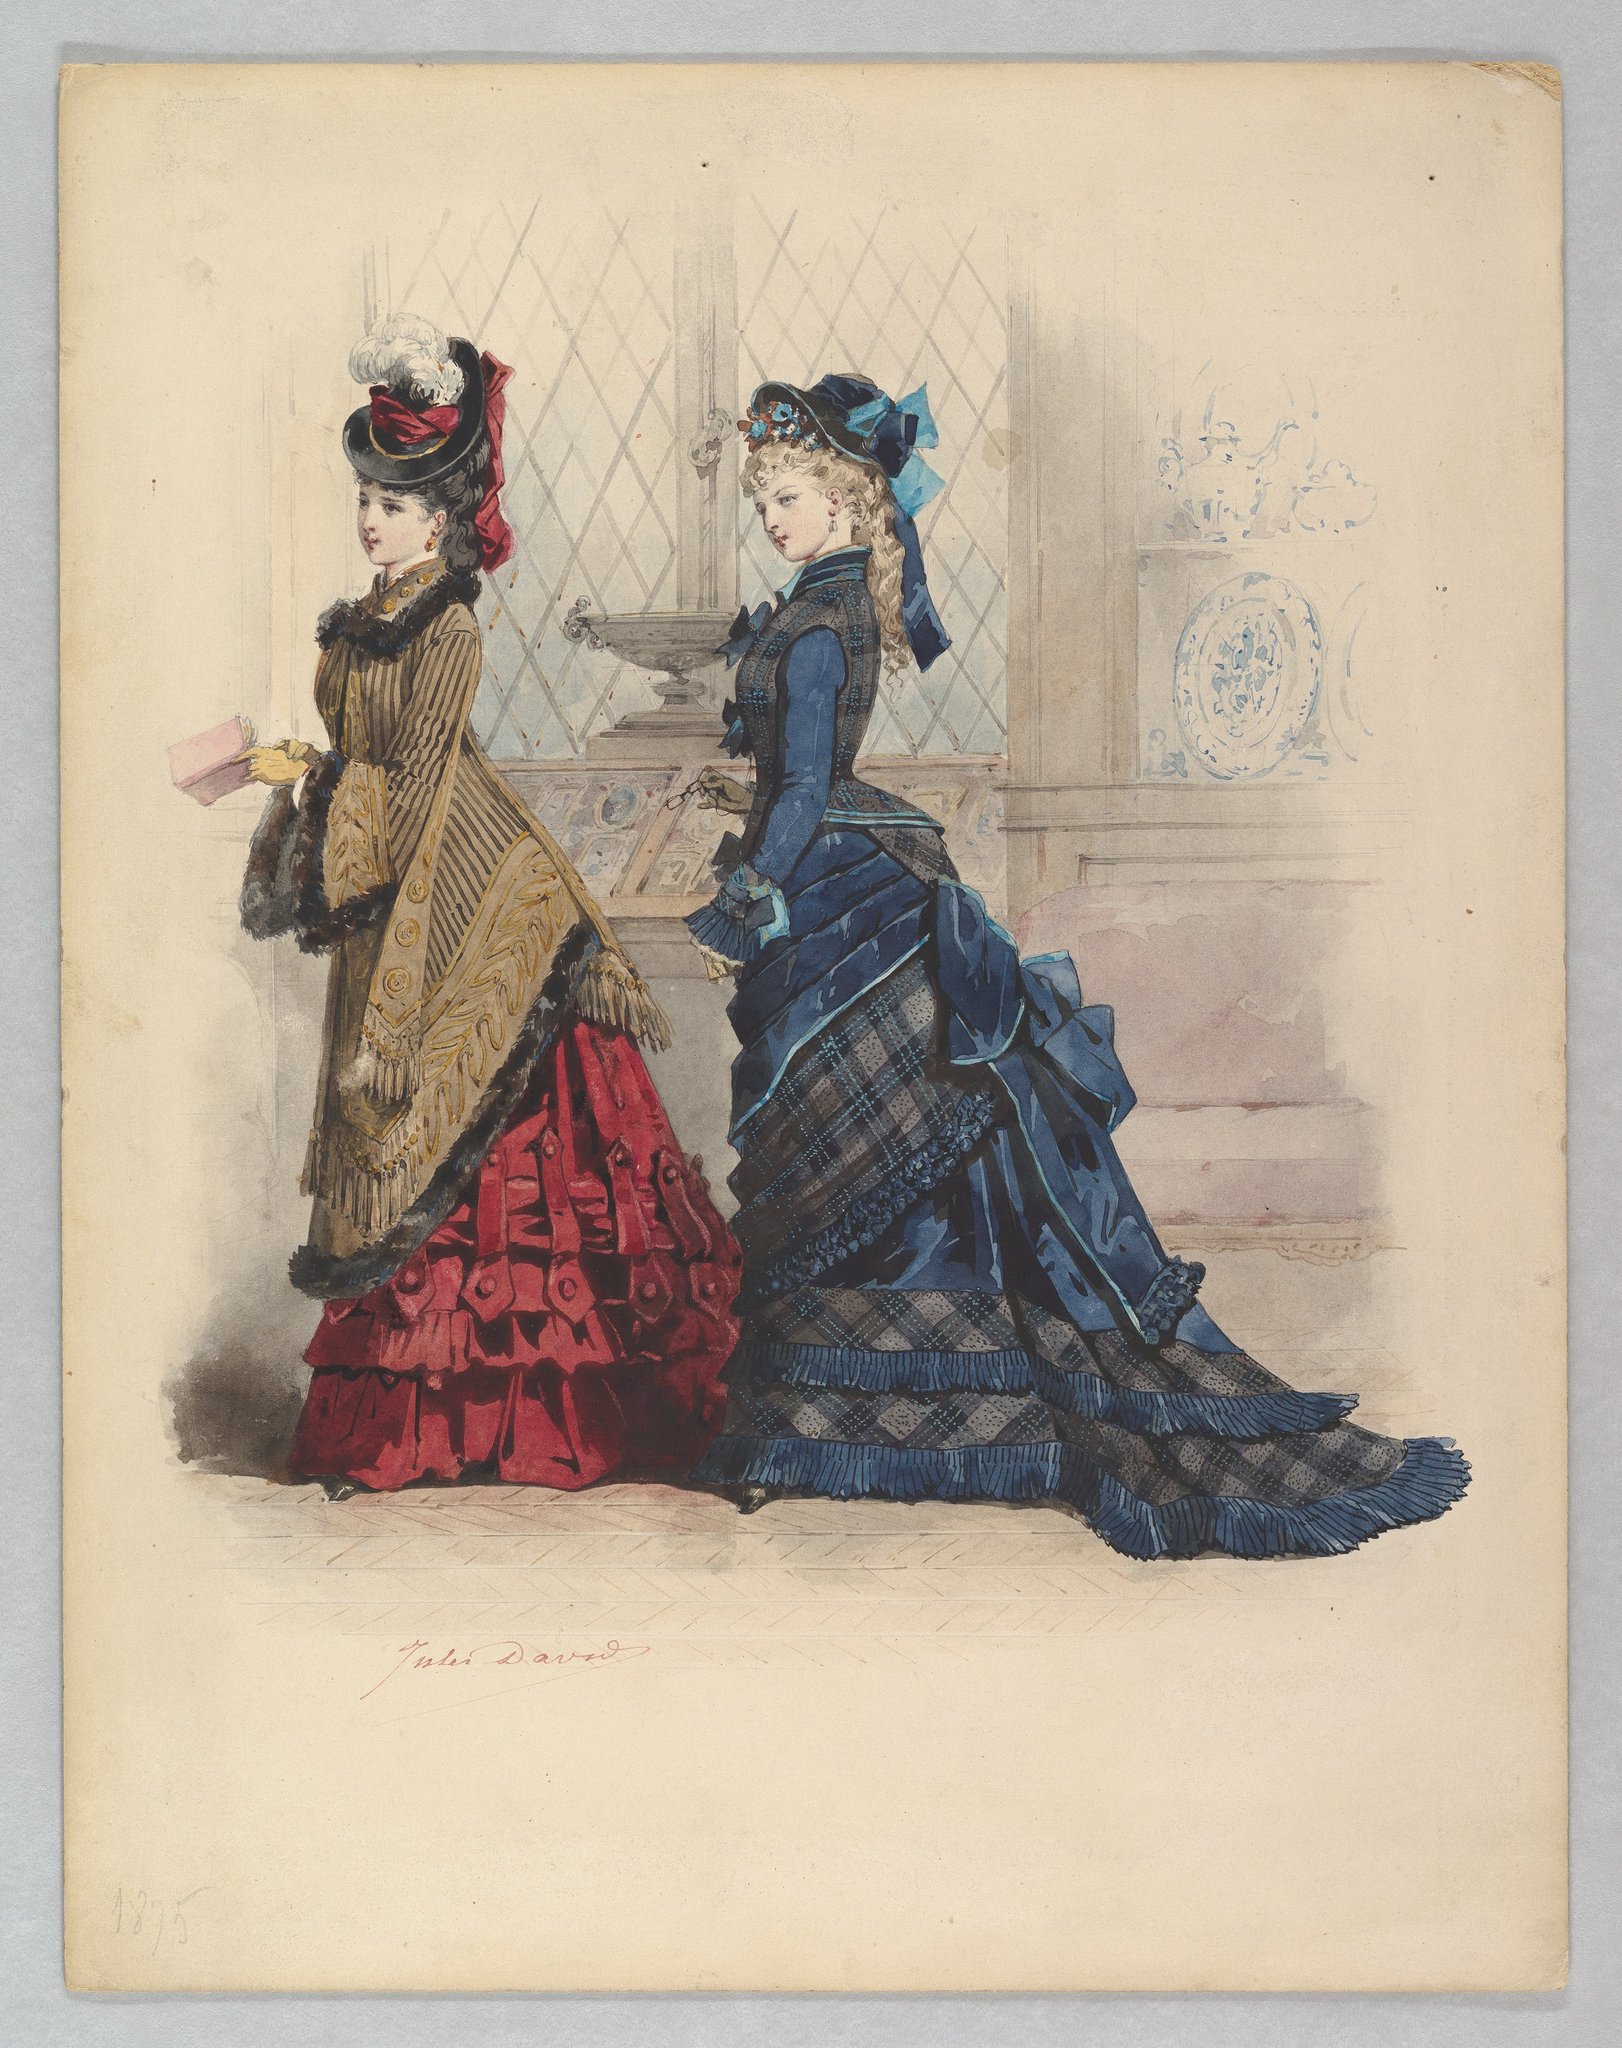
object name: drawing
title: Two Women in Day Dresses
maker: jules david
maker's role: artist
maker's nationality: french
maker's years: 1808-1892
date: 1875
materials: watercolor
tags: women